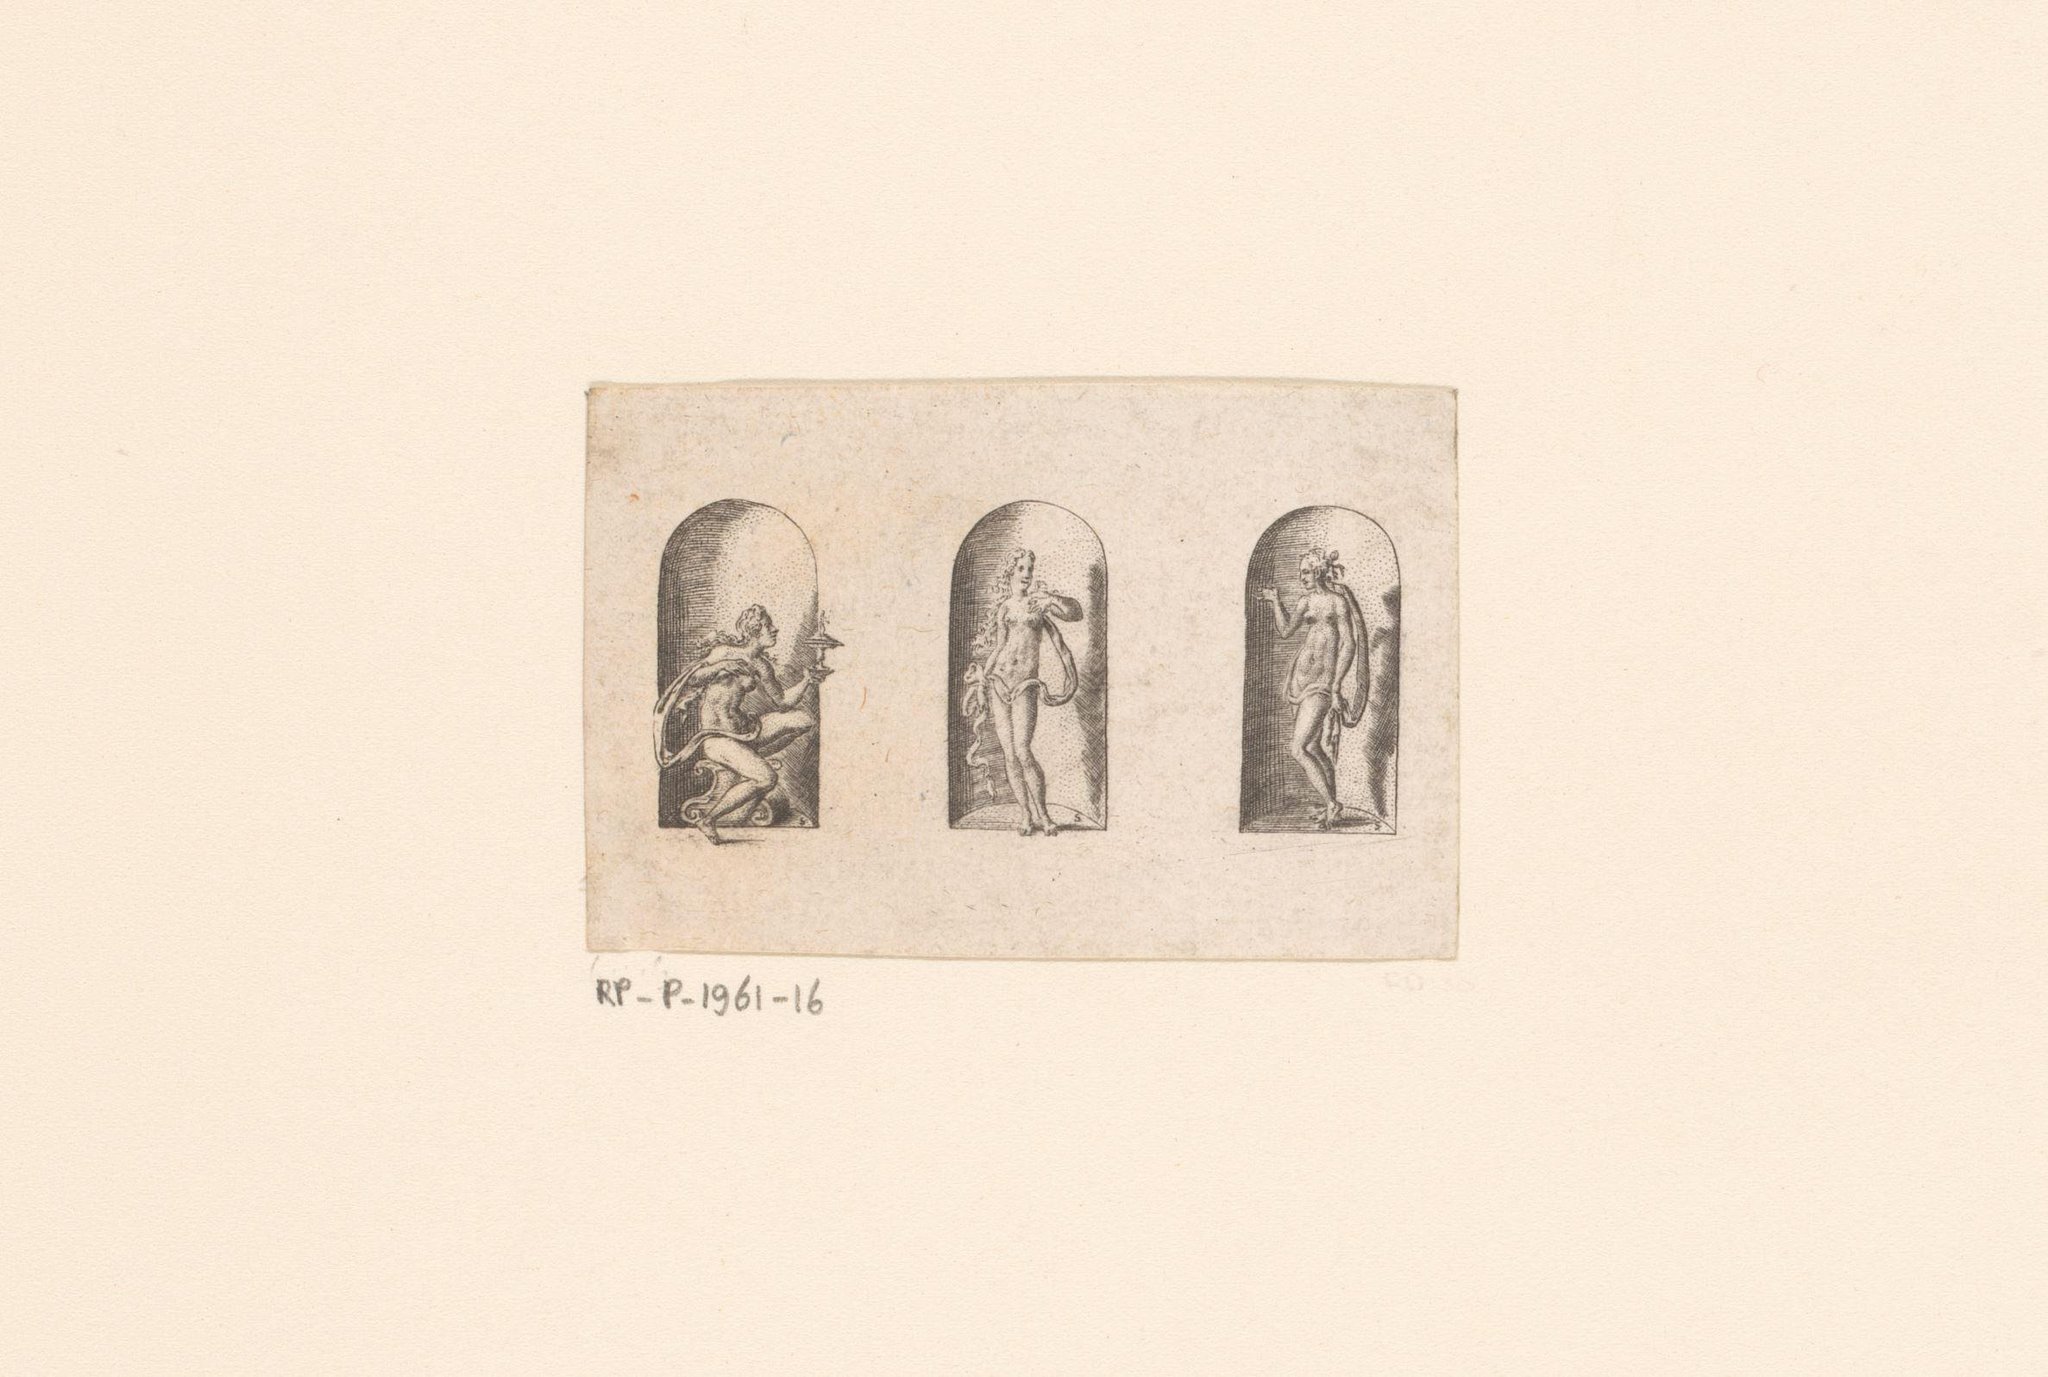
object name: print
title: Drie nissen waarvan een met Pandora en twee met Venus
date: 1578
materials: paper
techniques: engraving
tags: venus, standing on a shell, sails with her veil over the water (alternatively she is riding on a dolphin): venus marina, (story of) venus (aphrodite), (story of) pandora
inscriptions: collector's mark: Lugt 2228, collector's mark: Lugt 2760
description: Maakt deel uit van een zevendelige serie (inclusief titelprent) met op elke prent drie klassieke goden in nissen. Enkel de titelprent vormt een uitzondering. Hier zijn twee in plaats van drie nissen weergegeven, waar de figuren geen goden voorstellen. Waarschijnlijk vervaardigde Delaune deze prenten tijdens zijn verblijf in Duitsland (Pollet, p. 693).